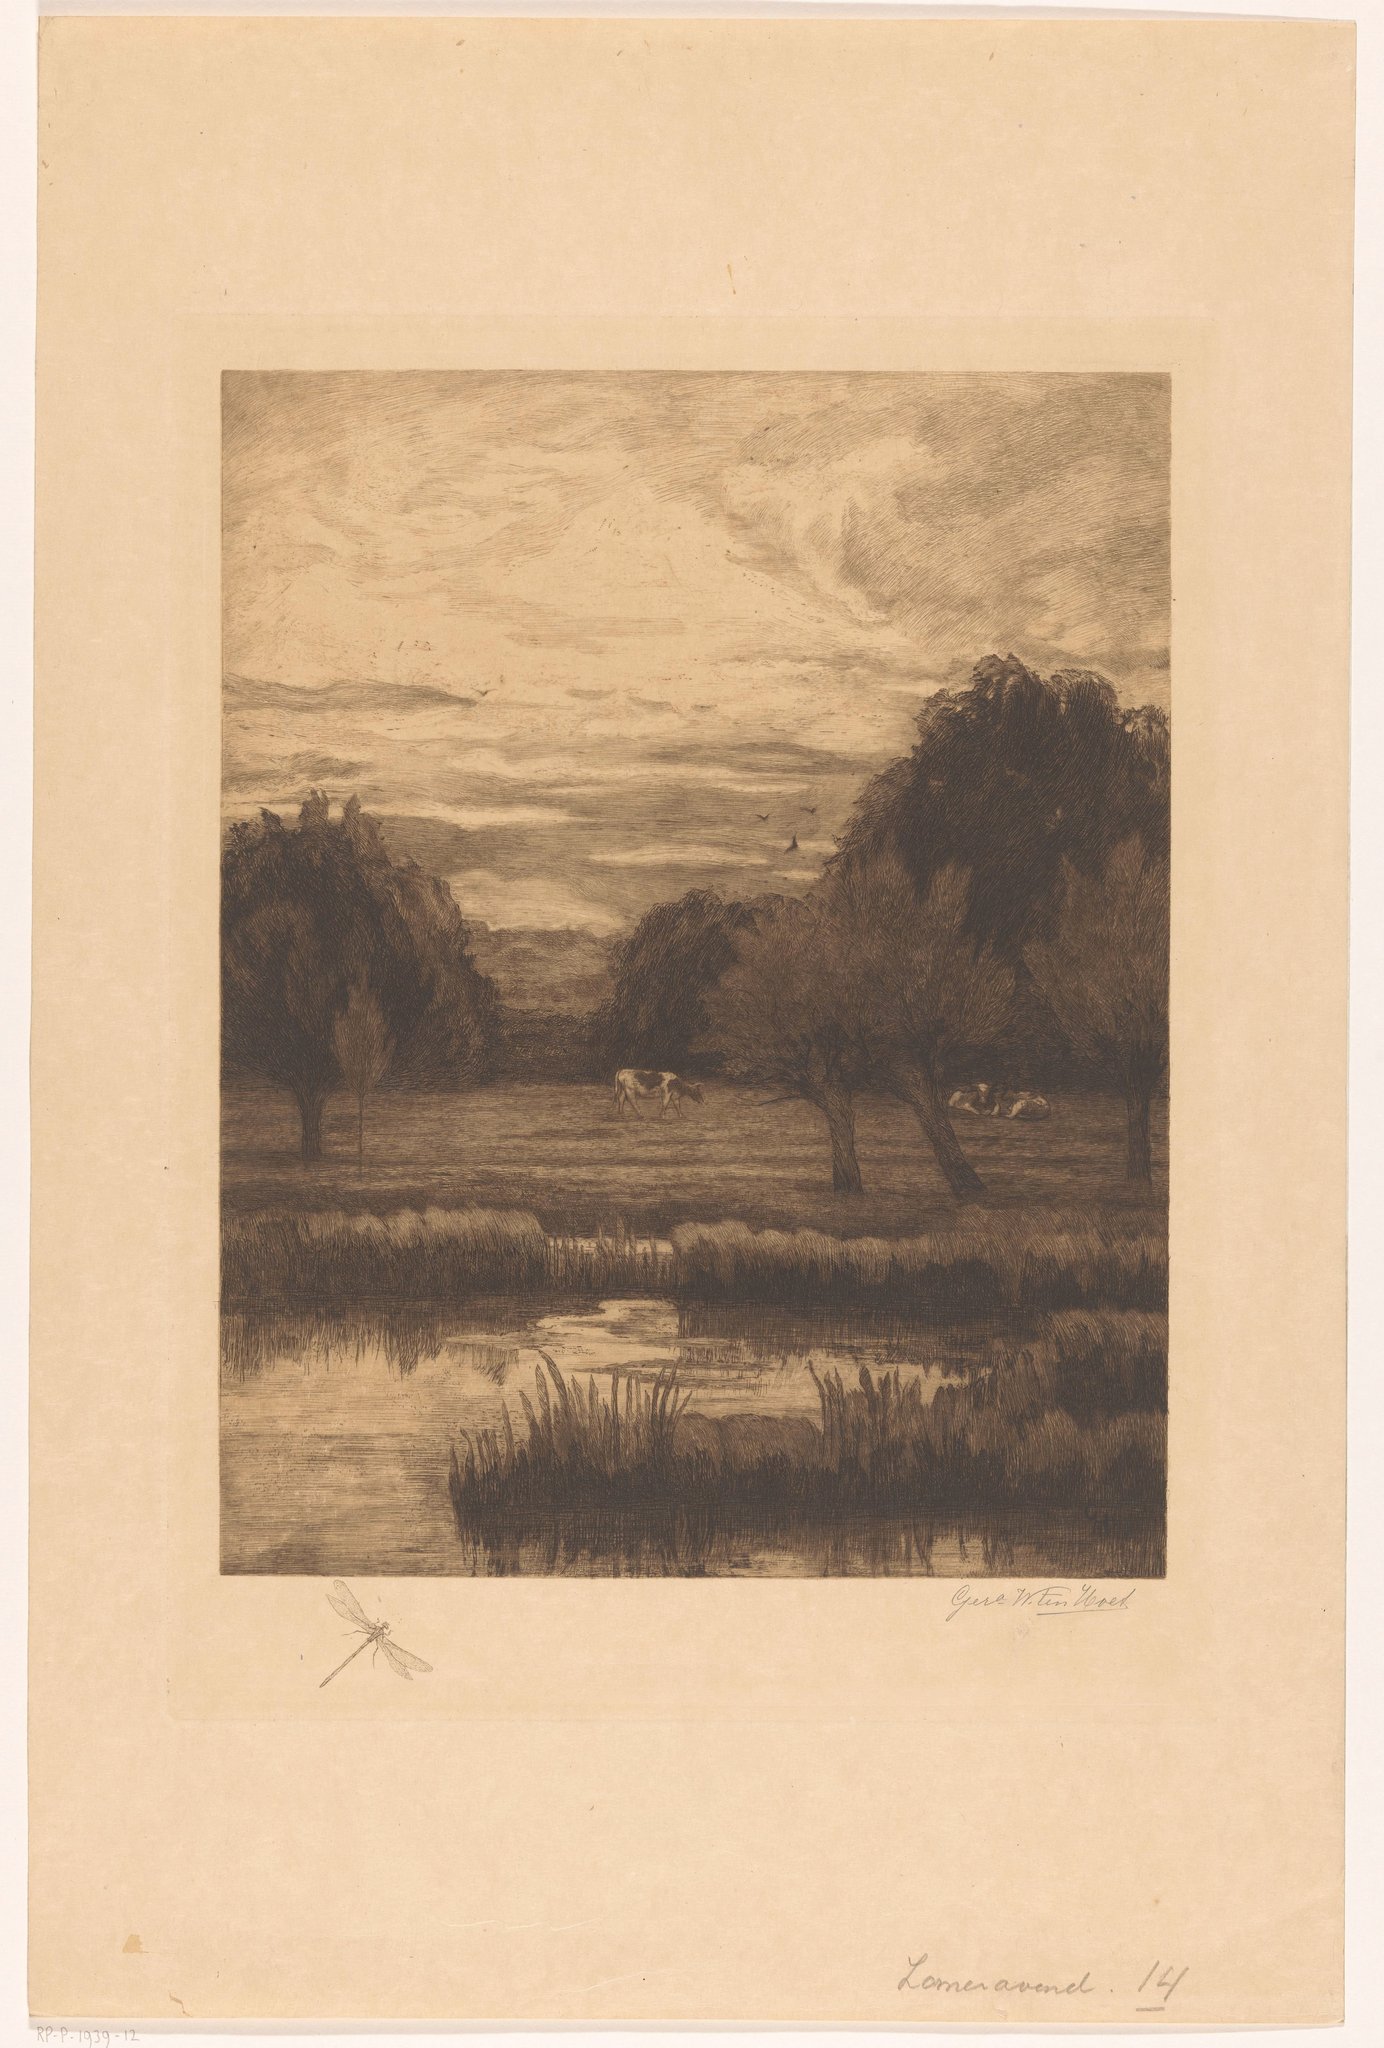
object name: print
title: Weidelandschap met grazende koeien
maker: gerarda wilhelmina ten hoet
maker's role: print maker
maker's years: 1857-1939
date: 1867-1939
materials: paper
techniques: etching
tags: insects: dragon-fly, meadow, pasture, bovine cattle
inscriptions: collector's mark: Lugt 2228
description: Op de voorgrond een poel. Linksonder een libelle.